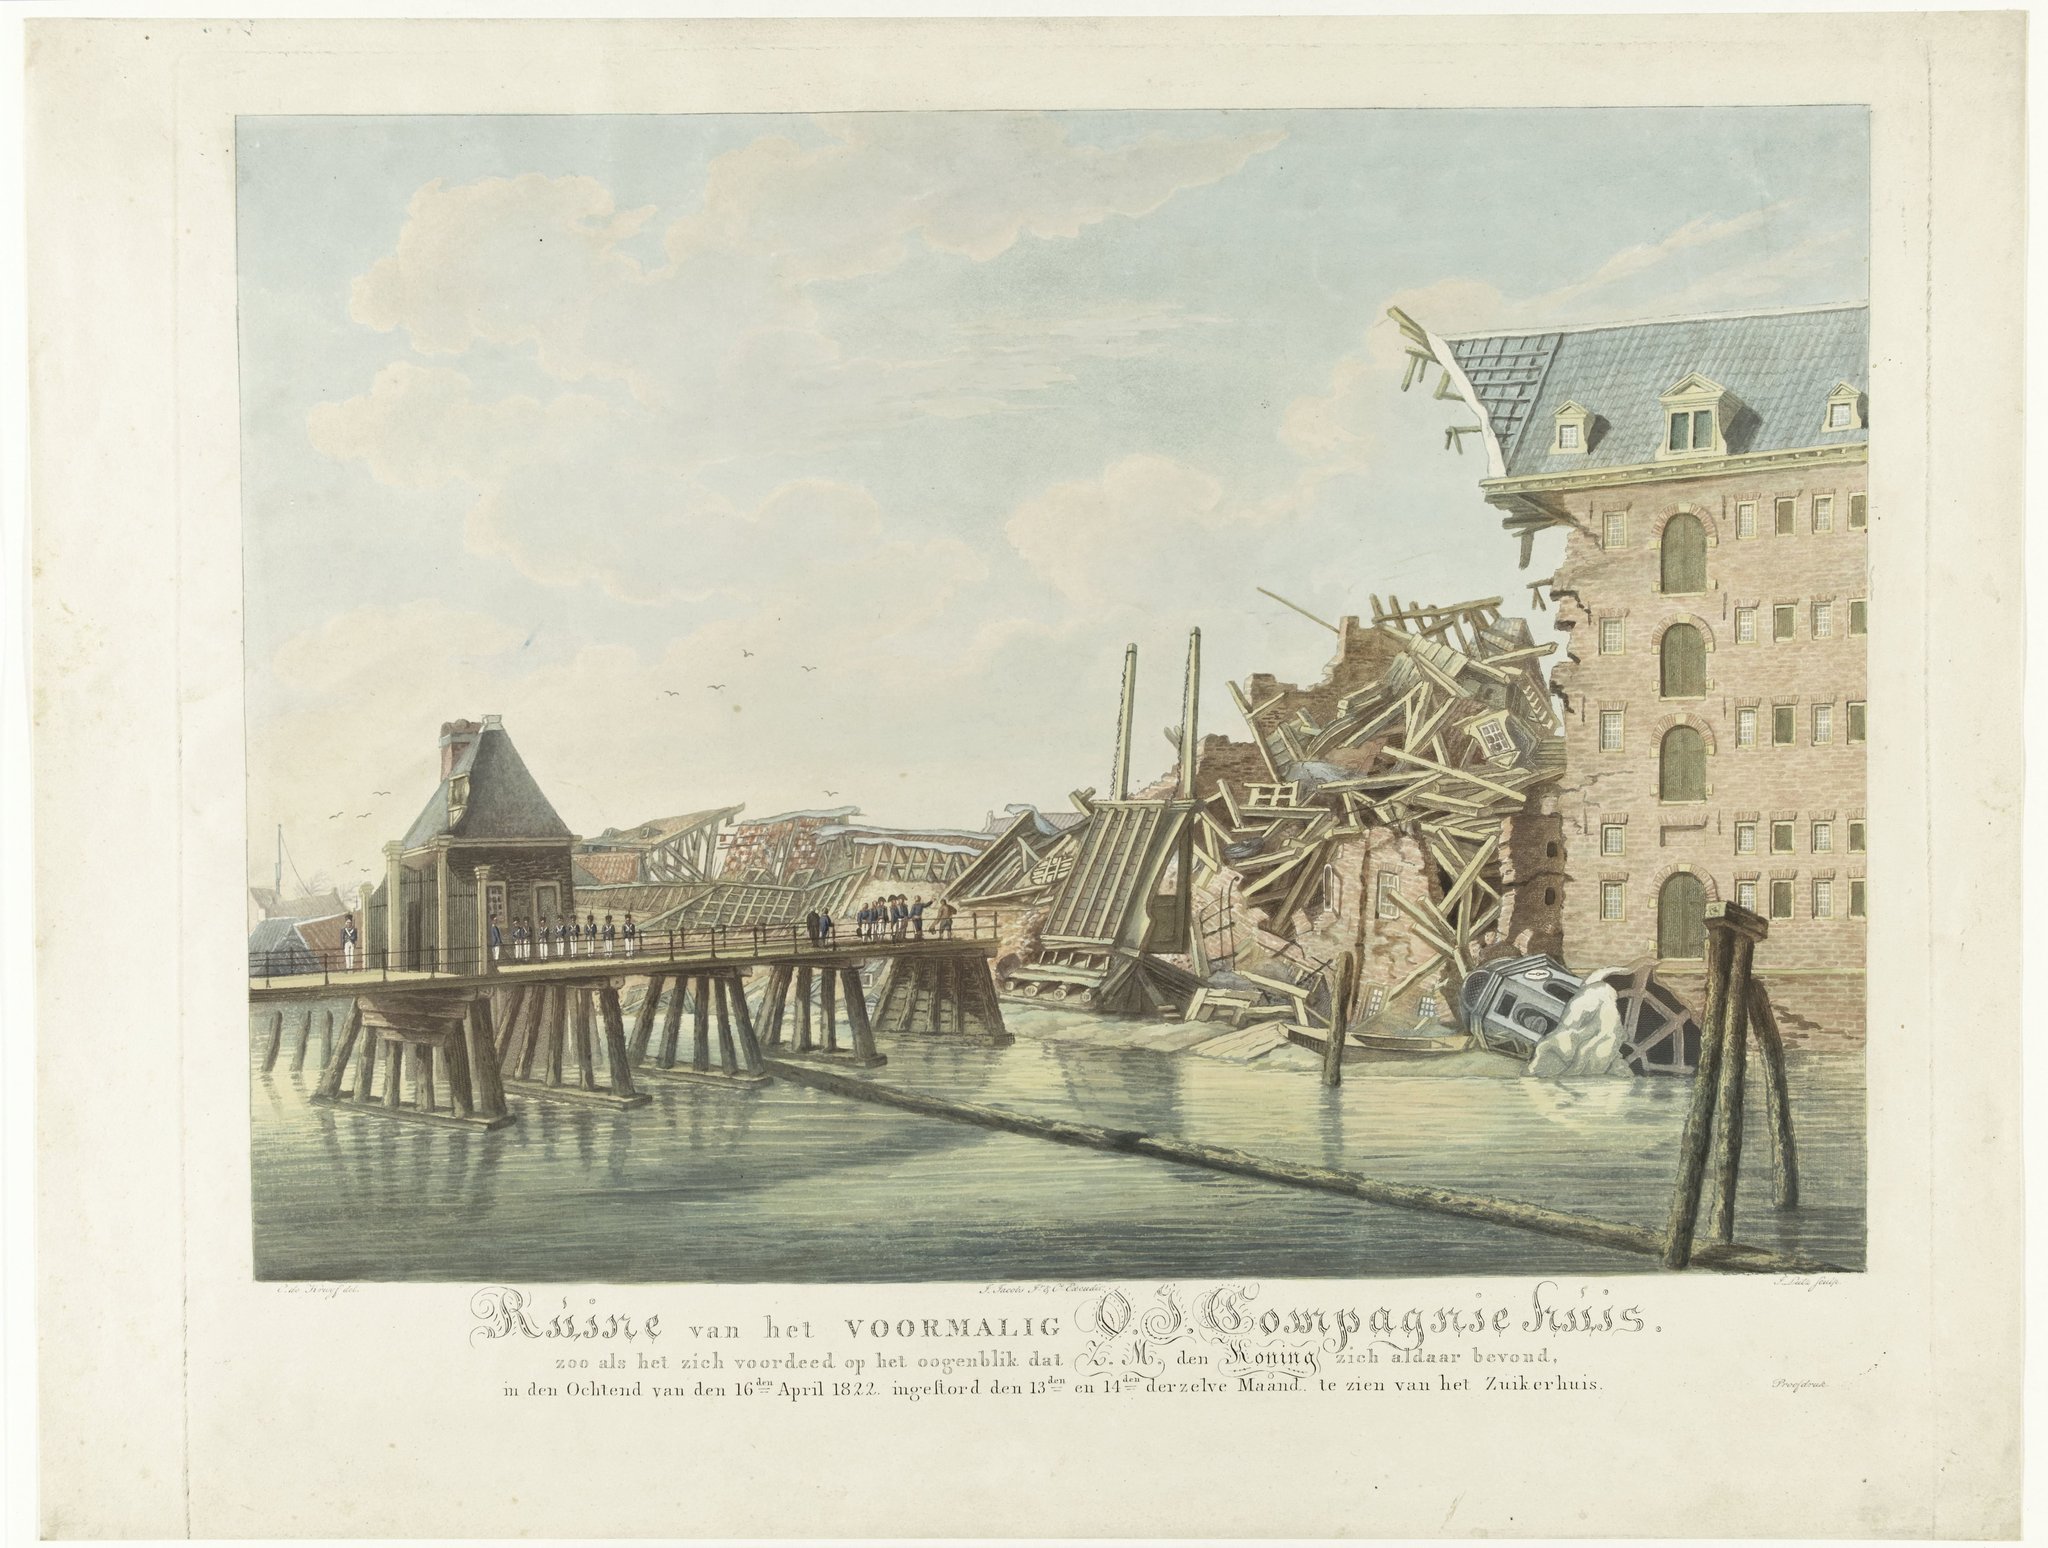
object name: print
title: Ruine van het voormalig O.I. Compagnie huis. zoo als het zich voordeed op het oogenblik dat Z.M. den Koning zich aldaar bevond, in den Ochtend van den 16den April 1822. ingestord den 13den en 14den derzelve Maand, te zien van het Zuikerhuis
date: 1822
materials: paper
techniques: etching, hand coloring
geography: netherlands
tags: berlin, william i of the netherlands, ruin of a building ~ architecture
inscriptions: collector's mark: Lugt 2228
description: Koning Willem I bezoekt de ruïne van het Oost-Indisch Zeemagazijn te Amsterdam op 16 april, na de instorting op 13-14 april 1822. De koning aanschouwt de ruïnes vanaf de brug. Zie ook de pendant.